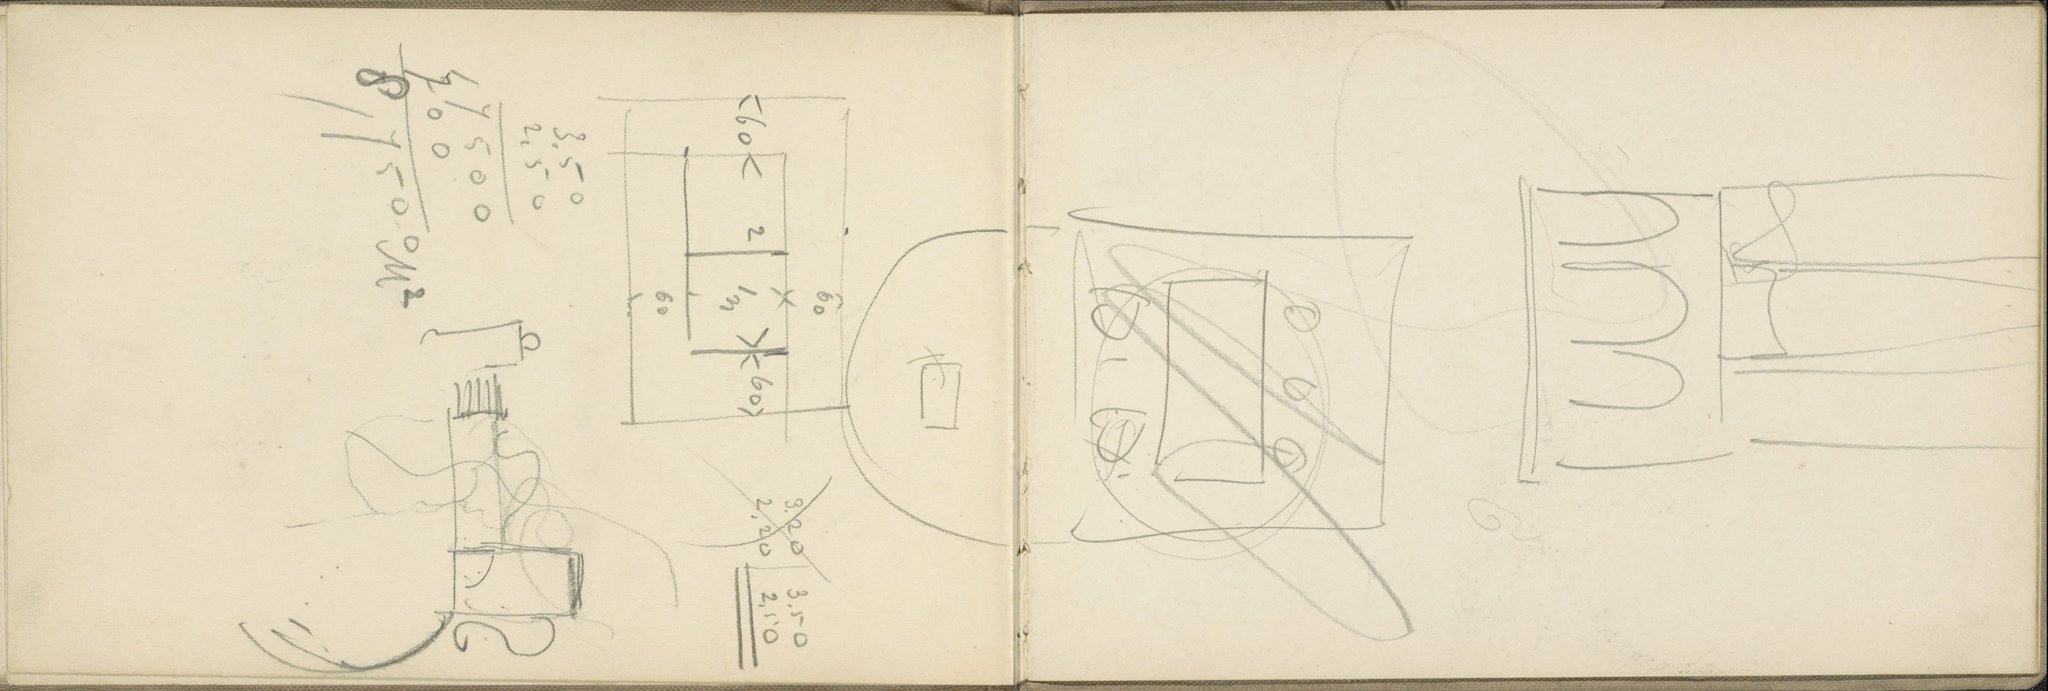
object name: sketchbook leaf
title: Architectuurontwerpen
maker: carel adolph lion cachet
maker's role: draughtsman, print maker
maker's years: 1864-1945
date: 1905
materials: paper, pencil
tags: plan ~ architecture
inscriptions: annotation: ‘[...]’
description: Blad 23 verso en 24 recto uit een schetsboek met 27 bladen.